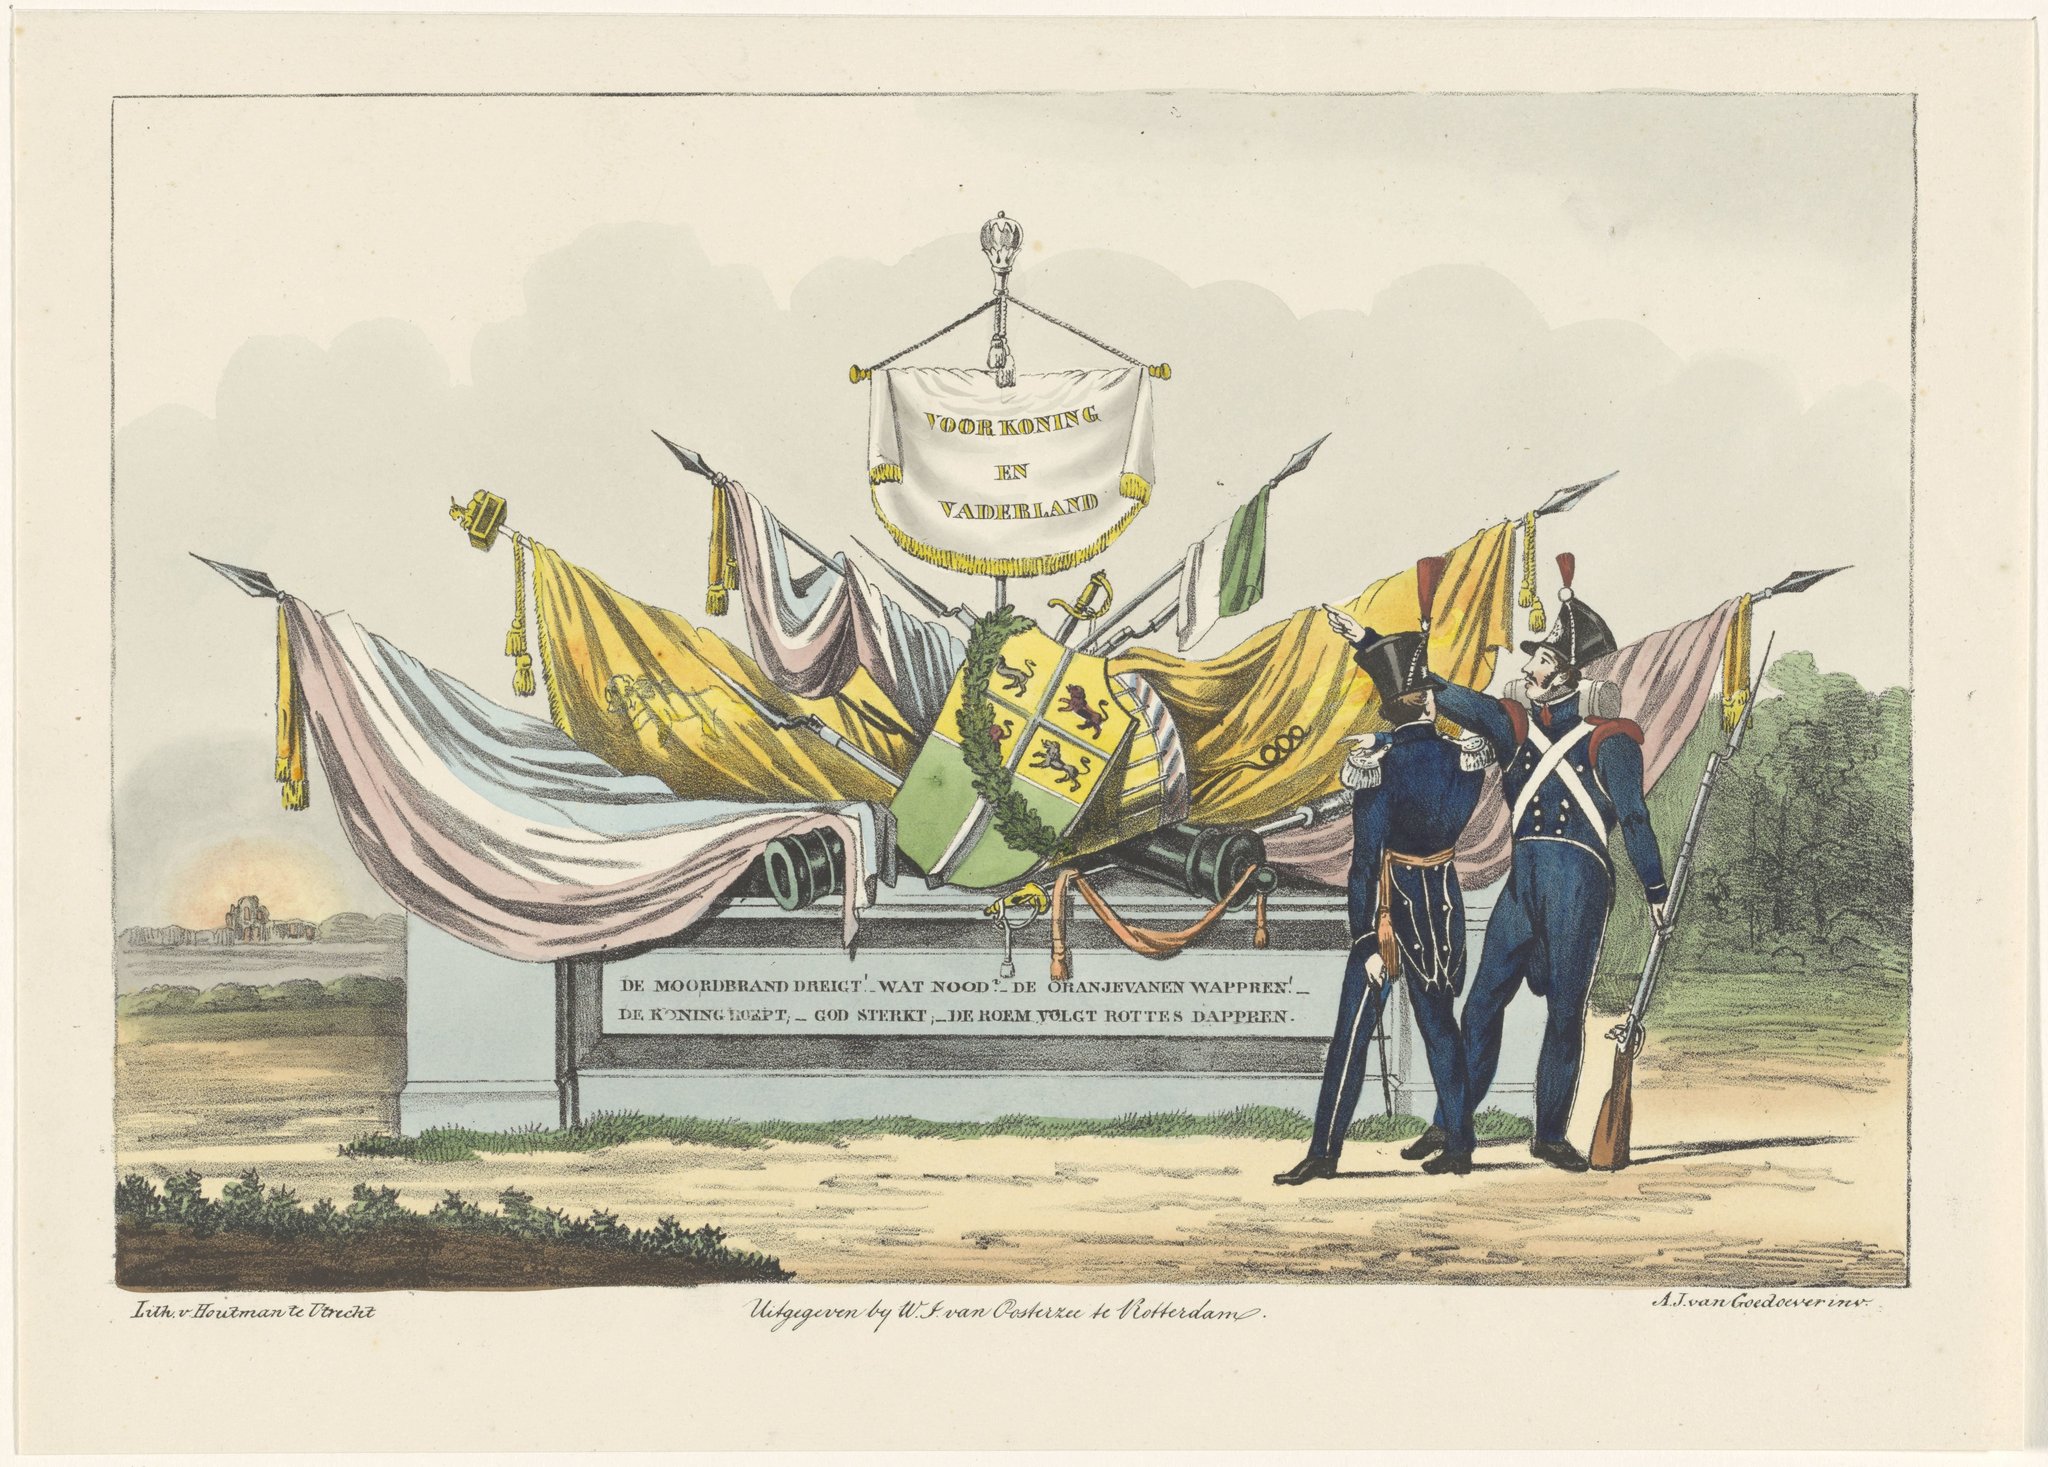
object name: print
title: Allegorie voor de Rotterdamse schutterij, 1830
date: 1830-1831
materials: paper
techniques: hand coloring, lithograph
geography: rotterdam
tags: 'tropaion', i.e. decorative ornament ~ weapons, warfare; military affairs (+ citizen soldiery, civil guard, citizen militia), rotterdam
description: Allegorie op het uittrekken van de vrijwillige Rotterdamse schutterij, 20 oktober 1830. Twee militairen voor een monument met een wapentrofee van vaandels en vlaggen, kanonnen en een banier met opschrift 'Voor Koning en Vaderland'. Op het monument een tweeregelig opschrift. In de verte een brandende stad.